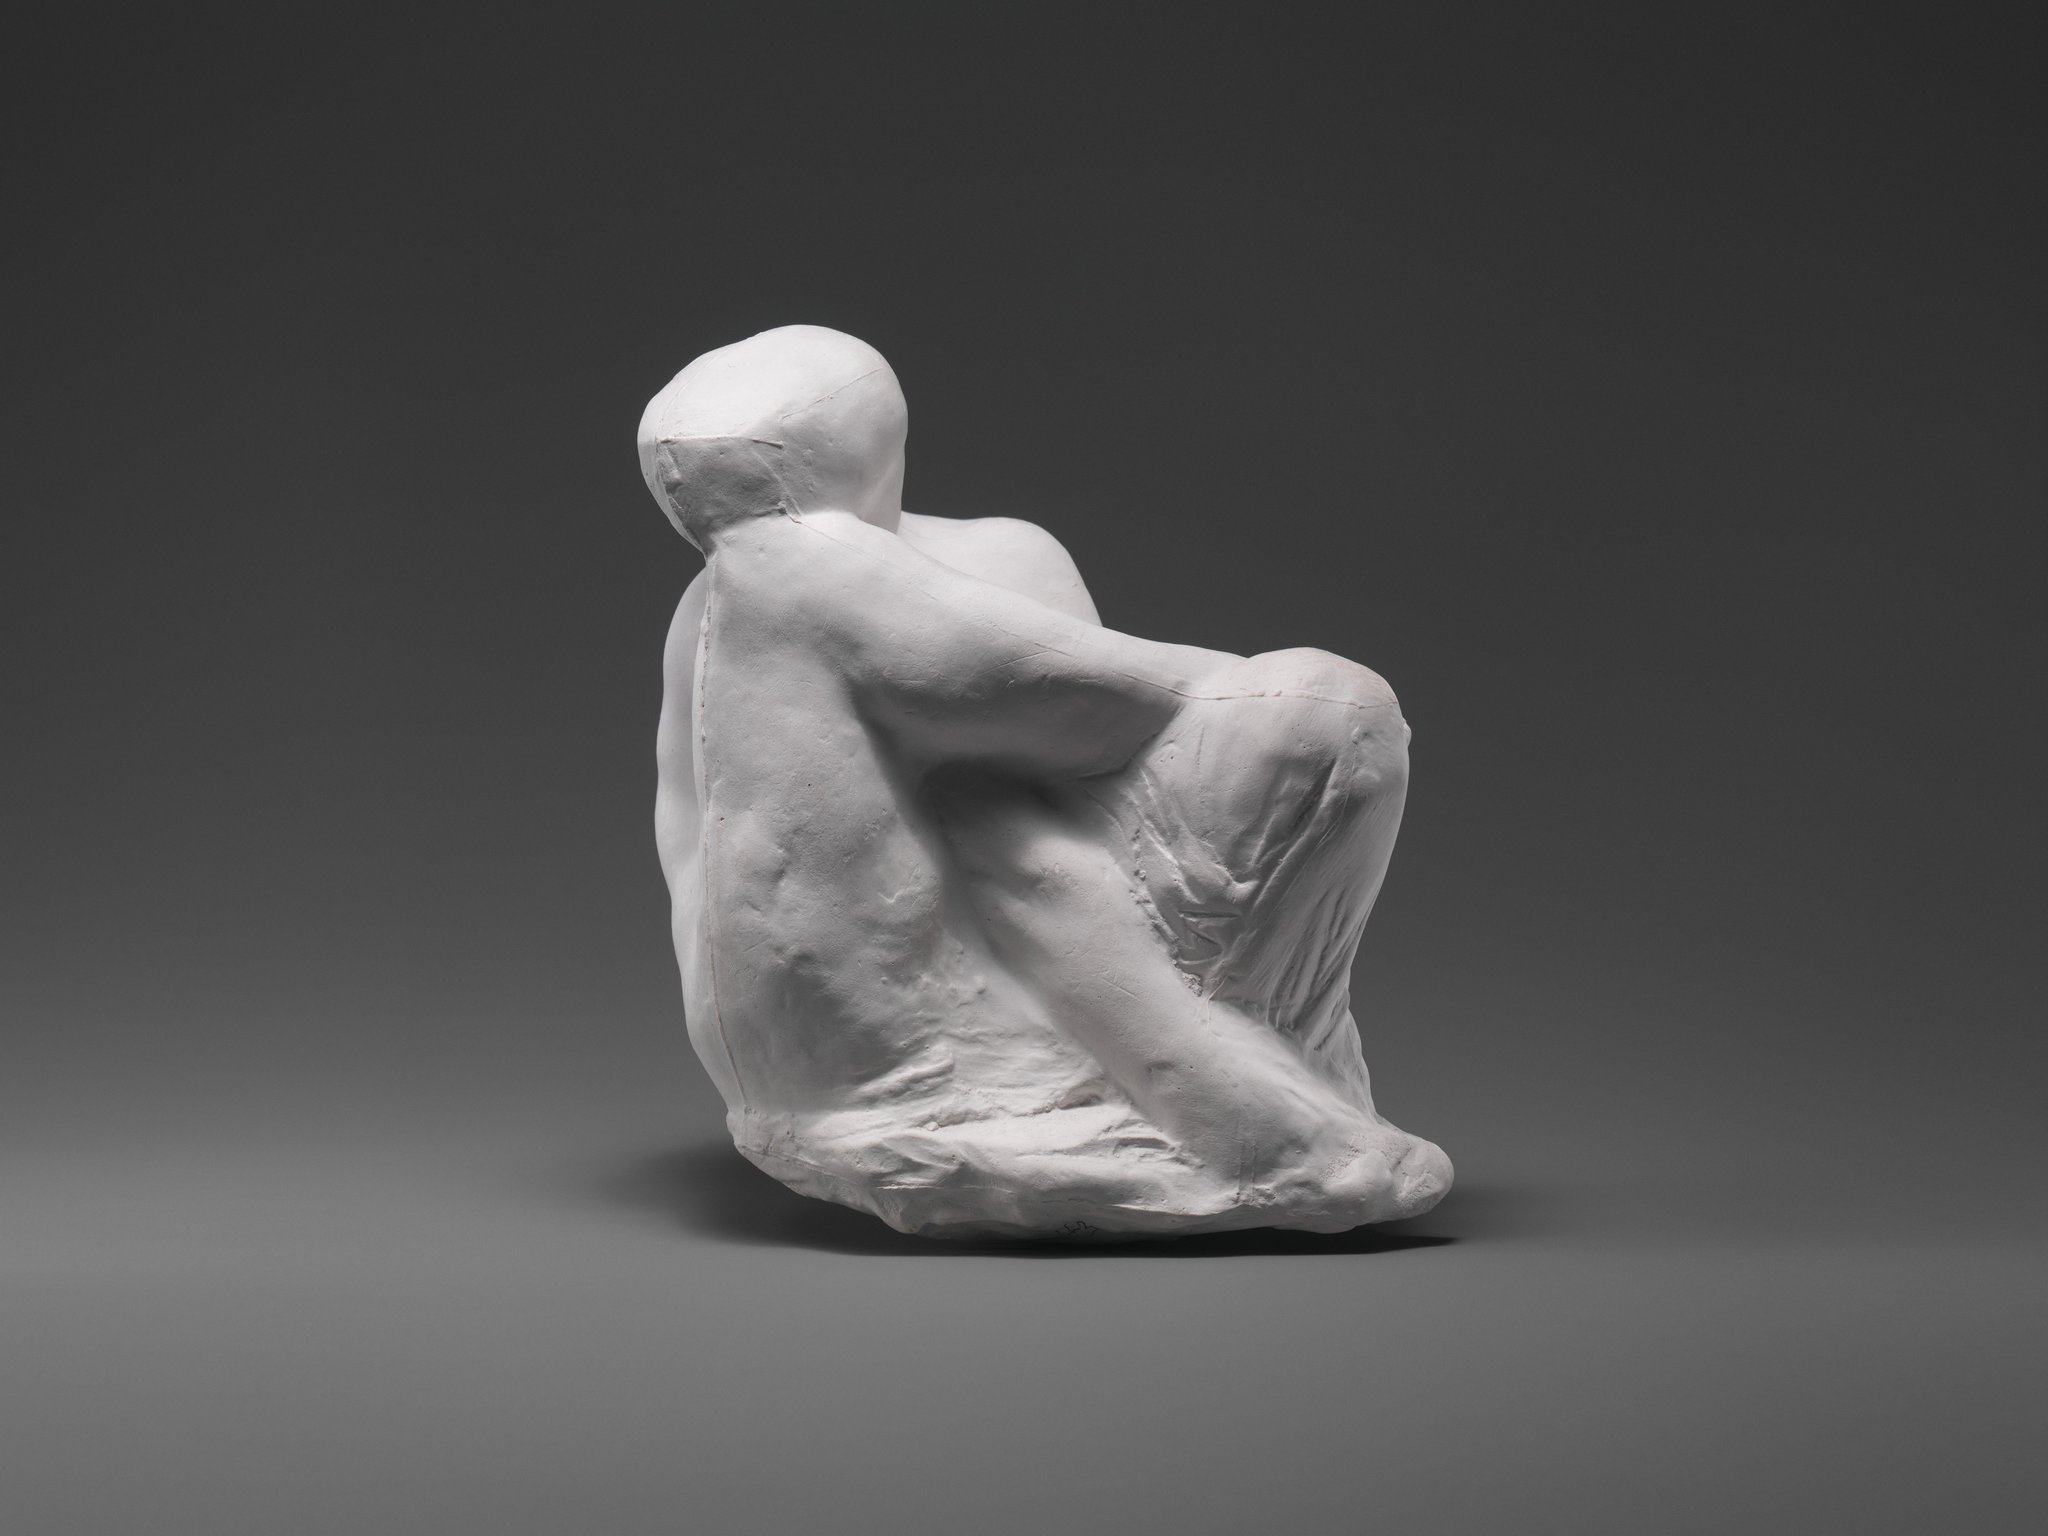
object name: cast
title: Study for Obsession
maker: auguste rodin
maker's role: artist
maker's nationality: french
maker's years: 1840-1917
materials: plaster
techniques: casting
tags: female nudes